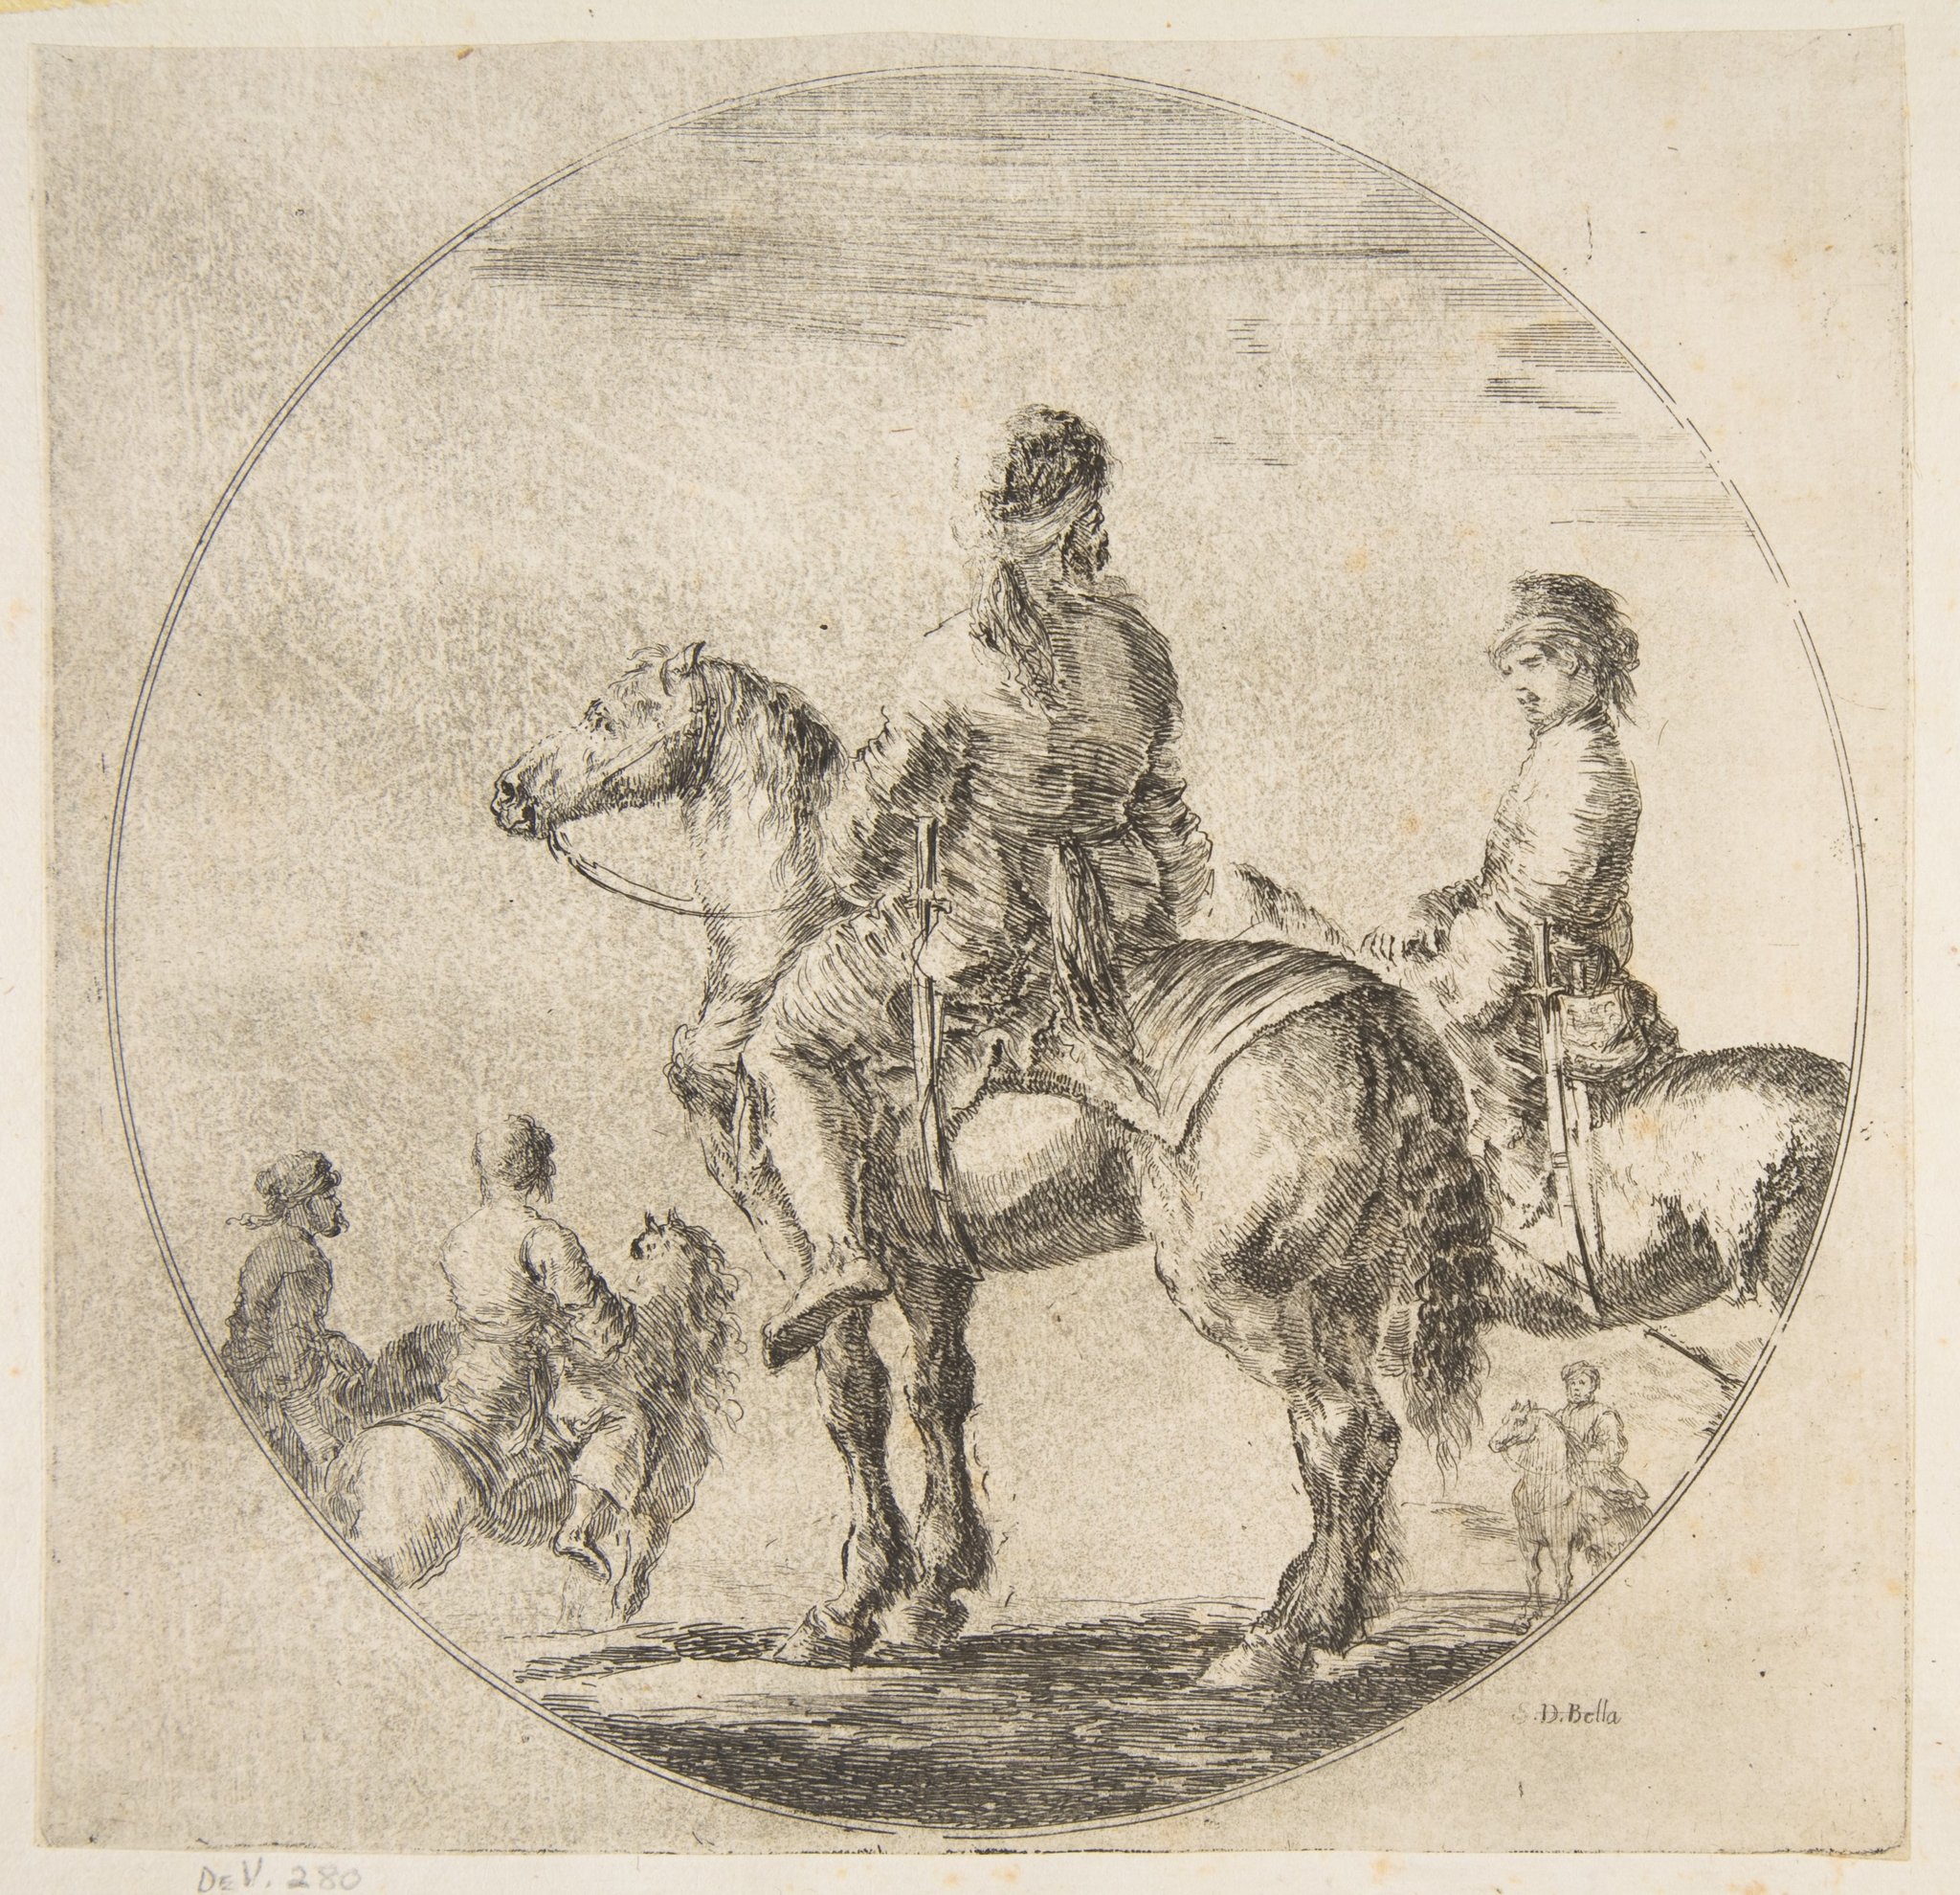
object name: print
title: Two Polish horsemen with their horses facing left, from "Figures on Horseback" (Cavaliers nègres, polonais et hongrois)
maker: stefano della bella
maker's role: artist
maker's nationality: italian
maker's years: 1610-1664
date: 1651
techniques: etching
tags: men,horses